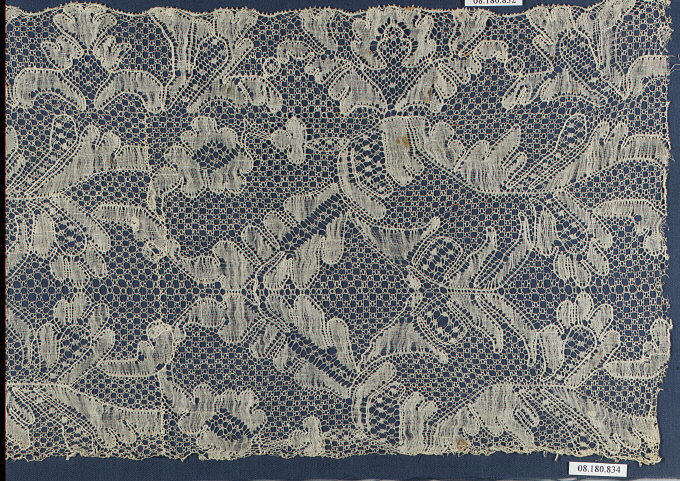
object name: fragment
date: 1701-1800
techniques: lace